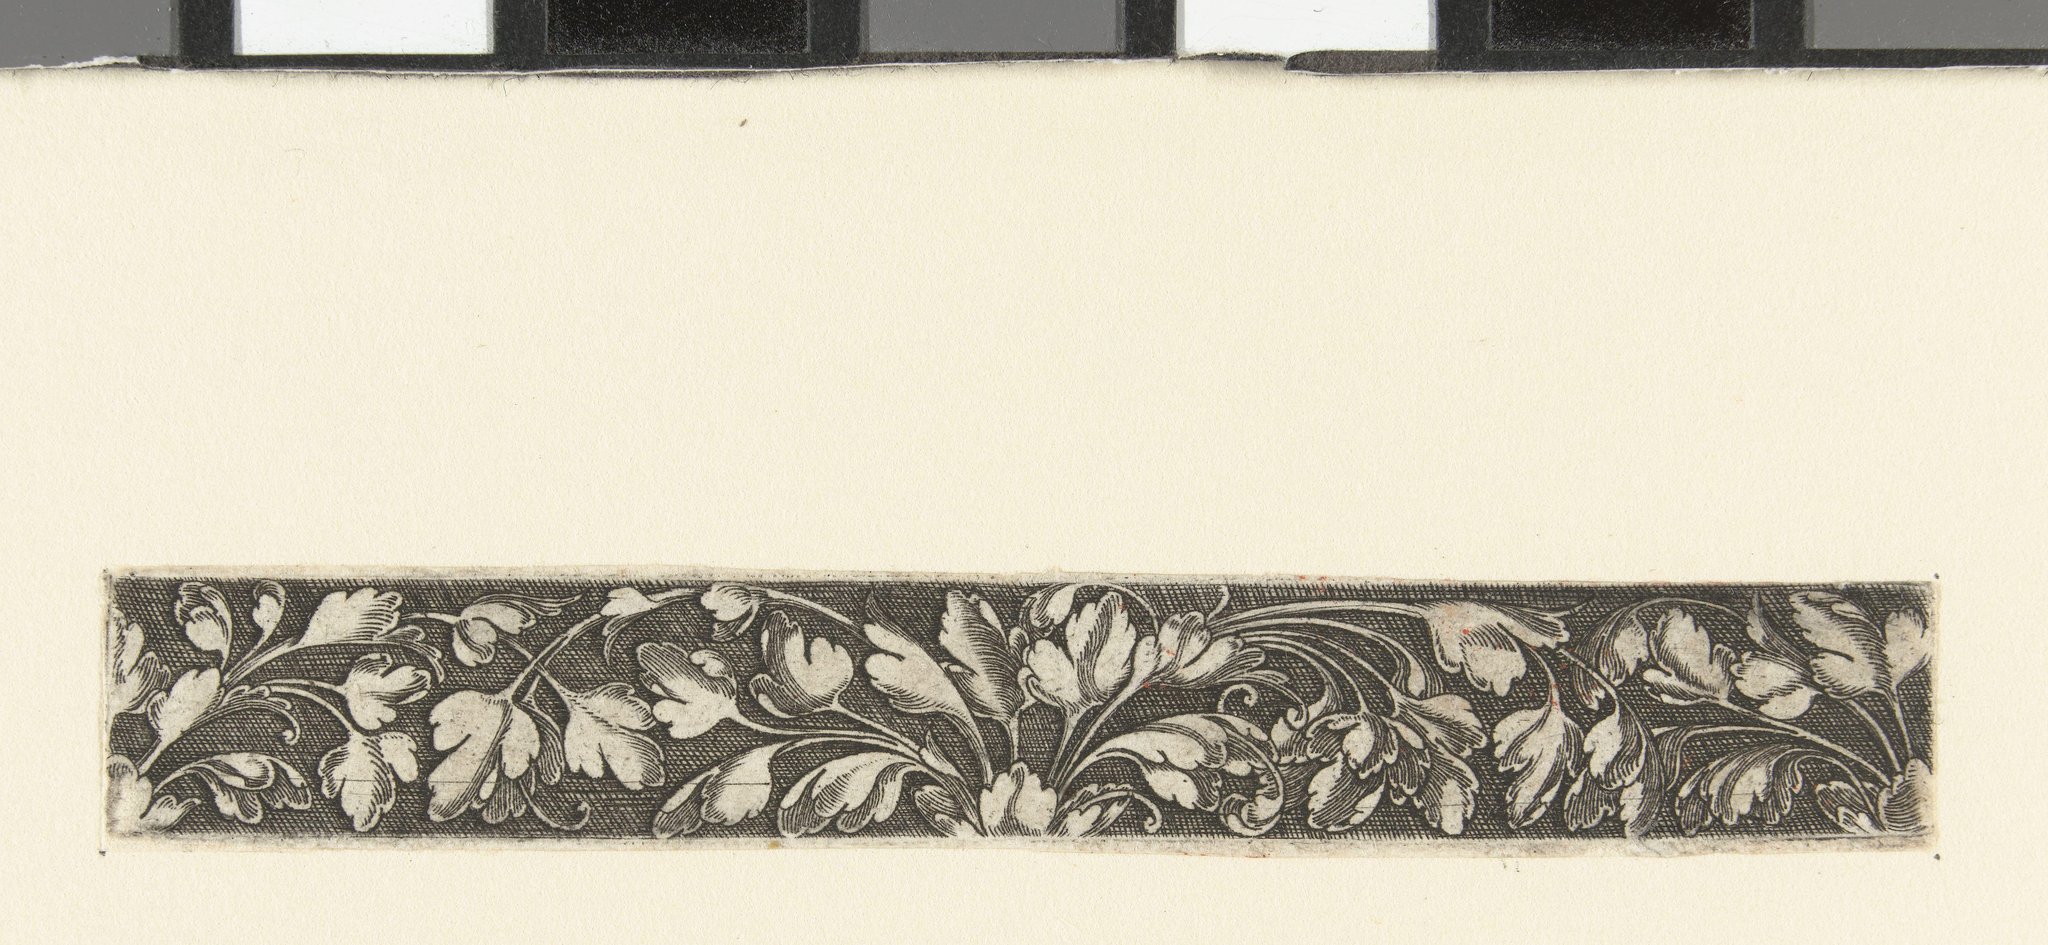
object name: print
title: Bladranken, ontspruitend vanuit bladeren in het midden en aan beide uiteinden van het fries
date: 1500-1600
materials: paper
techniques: engraving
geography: germany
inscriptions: collector's mark: Lugt 240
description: Gearceerde achtergrond. Eén van 11 bladen.